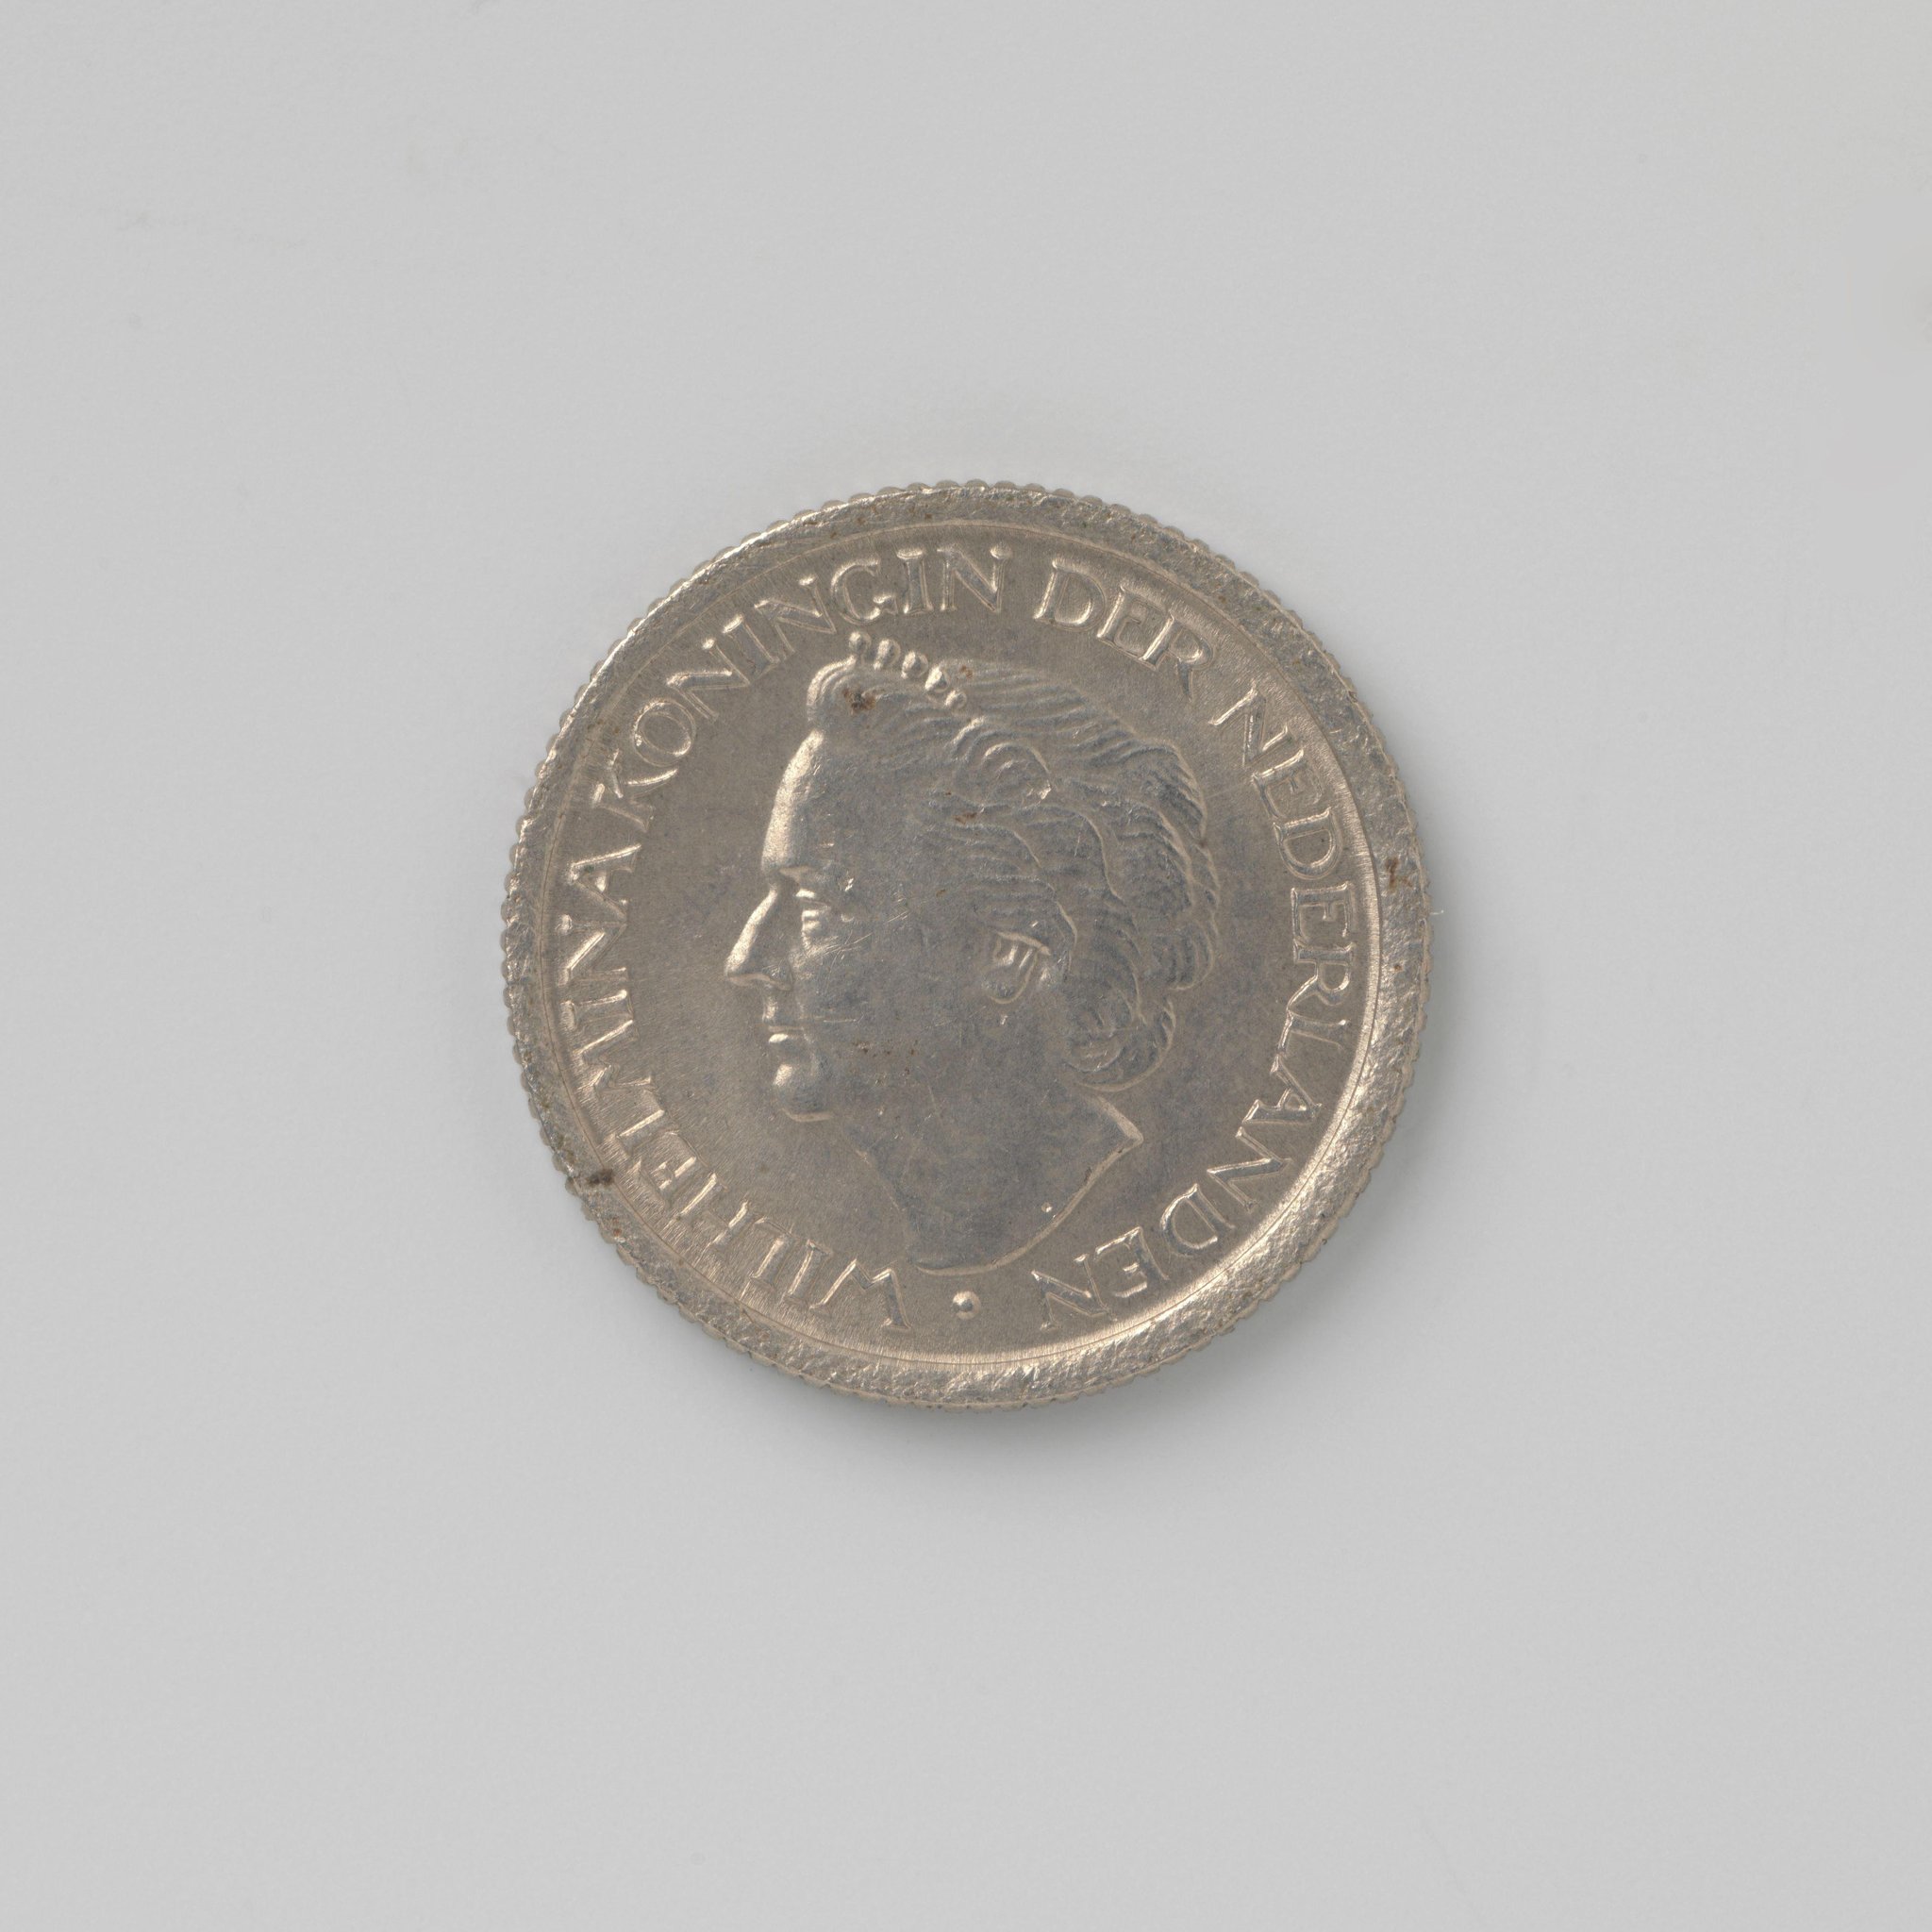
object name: coin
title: Nederland, 25 cent,1948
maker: wilhelmina of the netherlands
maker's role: print maker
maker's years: 1880-1962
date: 1948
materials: nickel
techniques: striking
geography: utrecht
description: Nikkelen munt. Voorzijde: hoofd naar links. Keerzijde: kroon, daaronder, tussen jaartal, waarde-aanduiding 25 cent. Kartelrand.